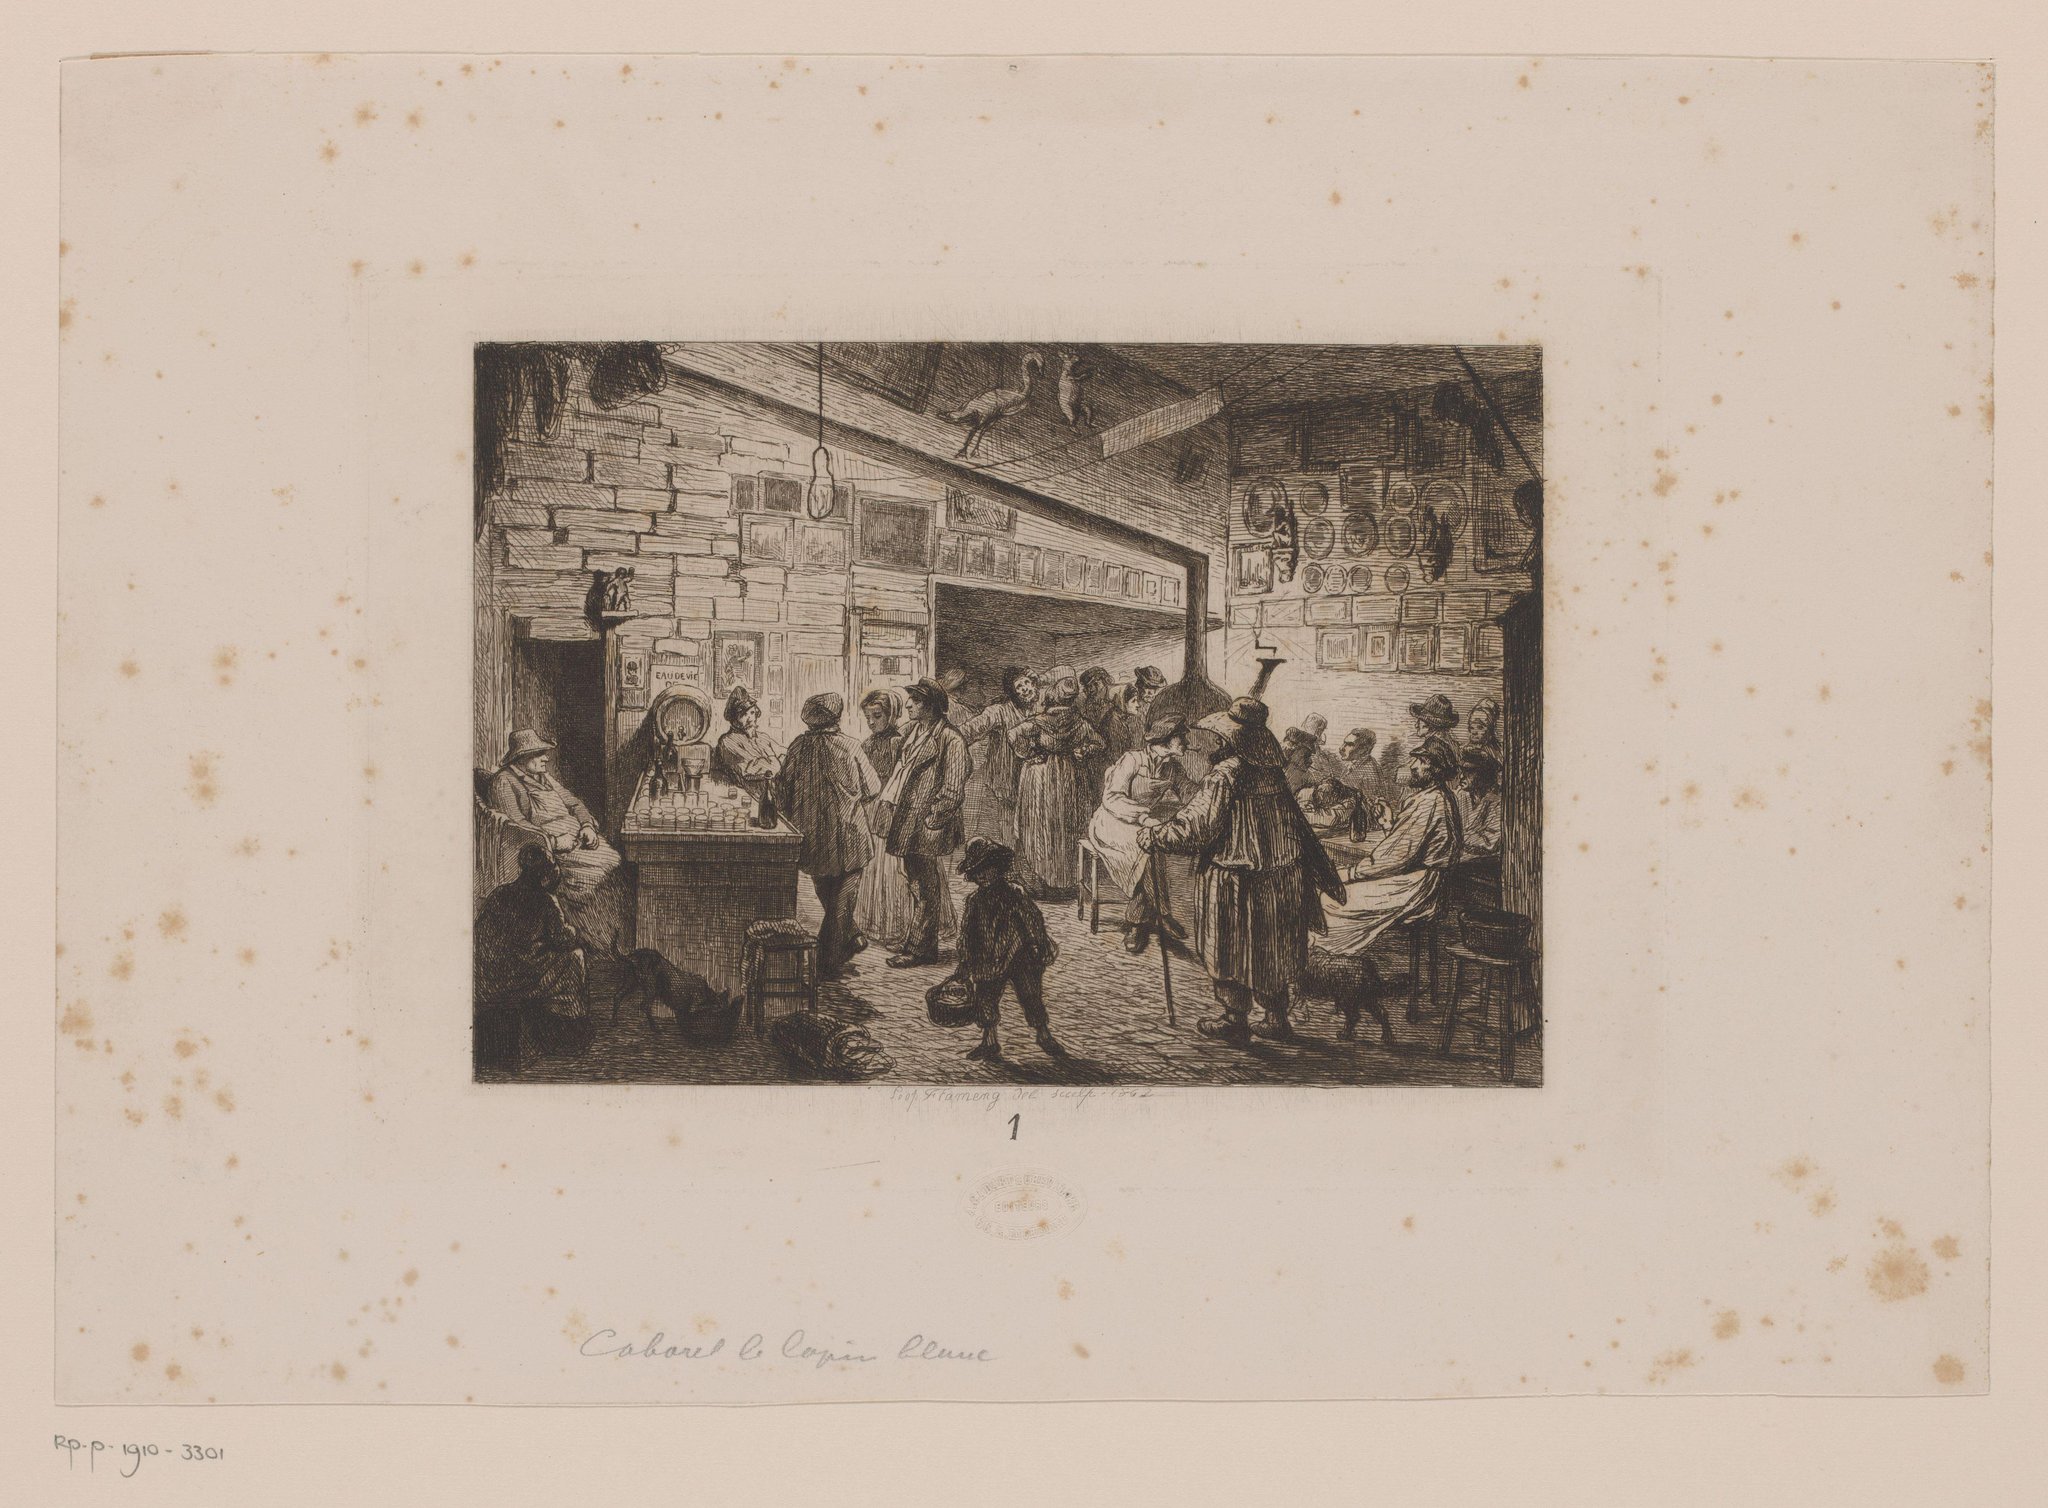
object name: print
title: Cabaret du Lapin Blanc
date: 1862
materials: paper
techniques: drypoint, etching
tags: inn, coffee-house, public house, etc., paris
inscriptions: workshop stamp: ‘A. Cadart editeur 3 rue St. Fiacre Paris’, collector's mark: Lugt 2228